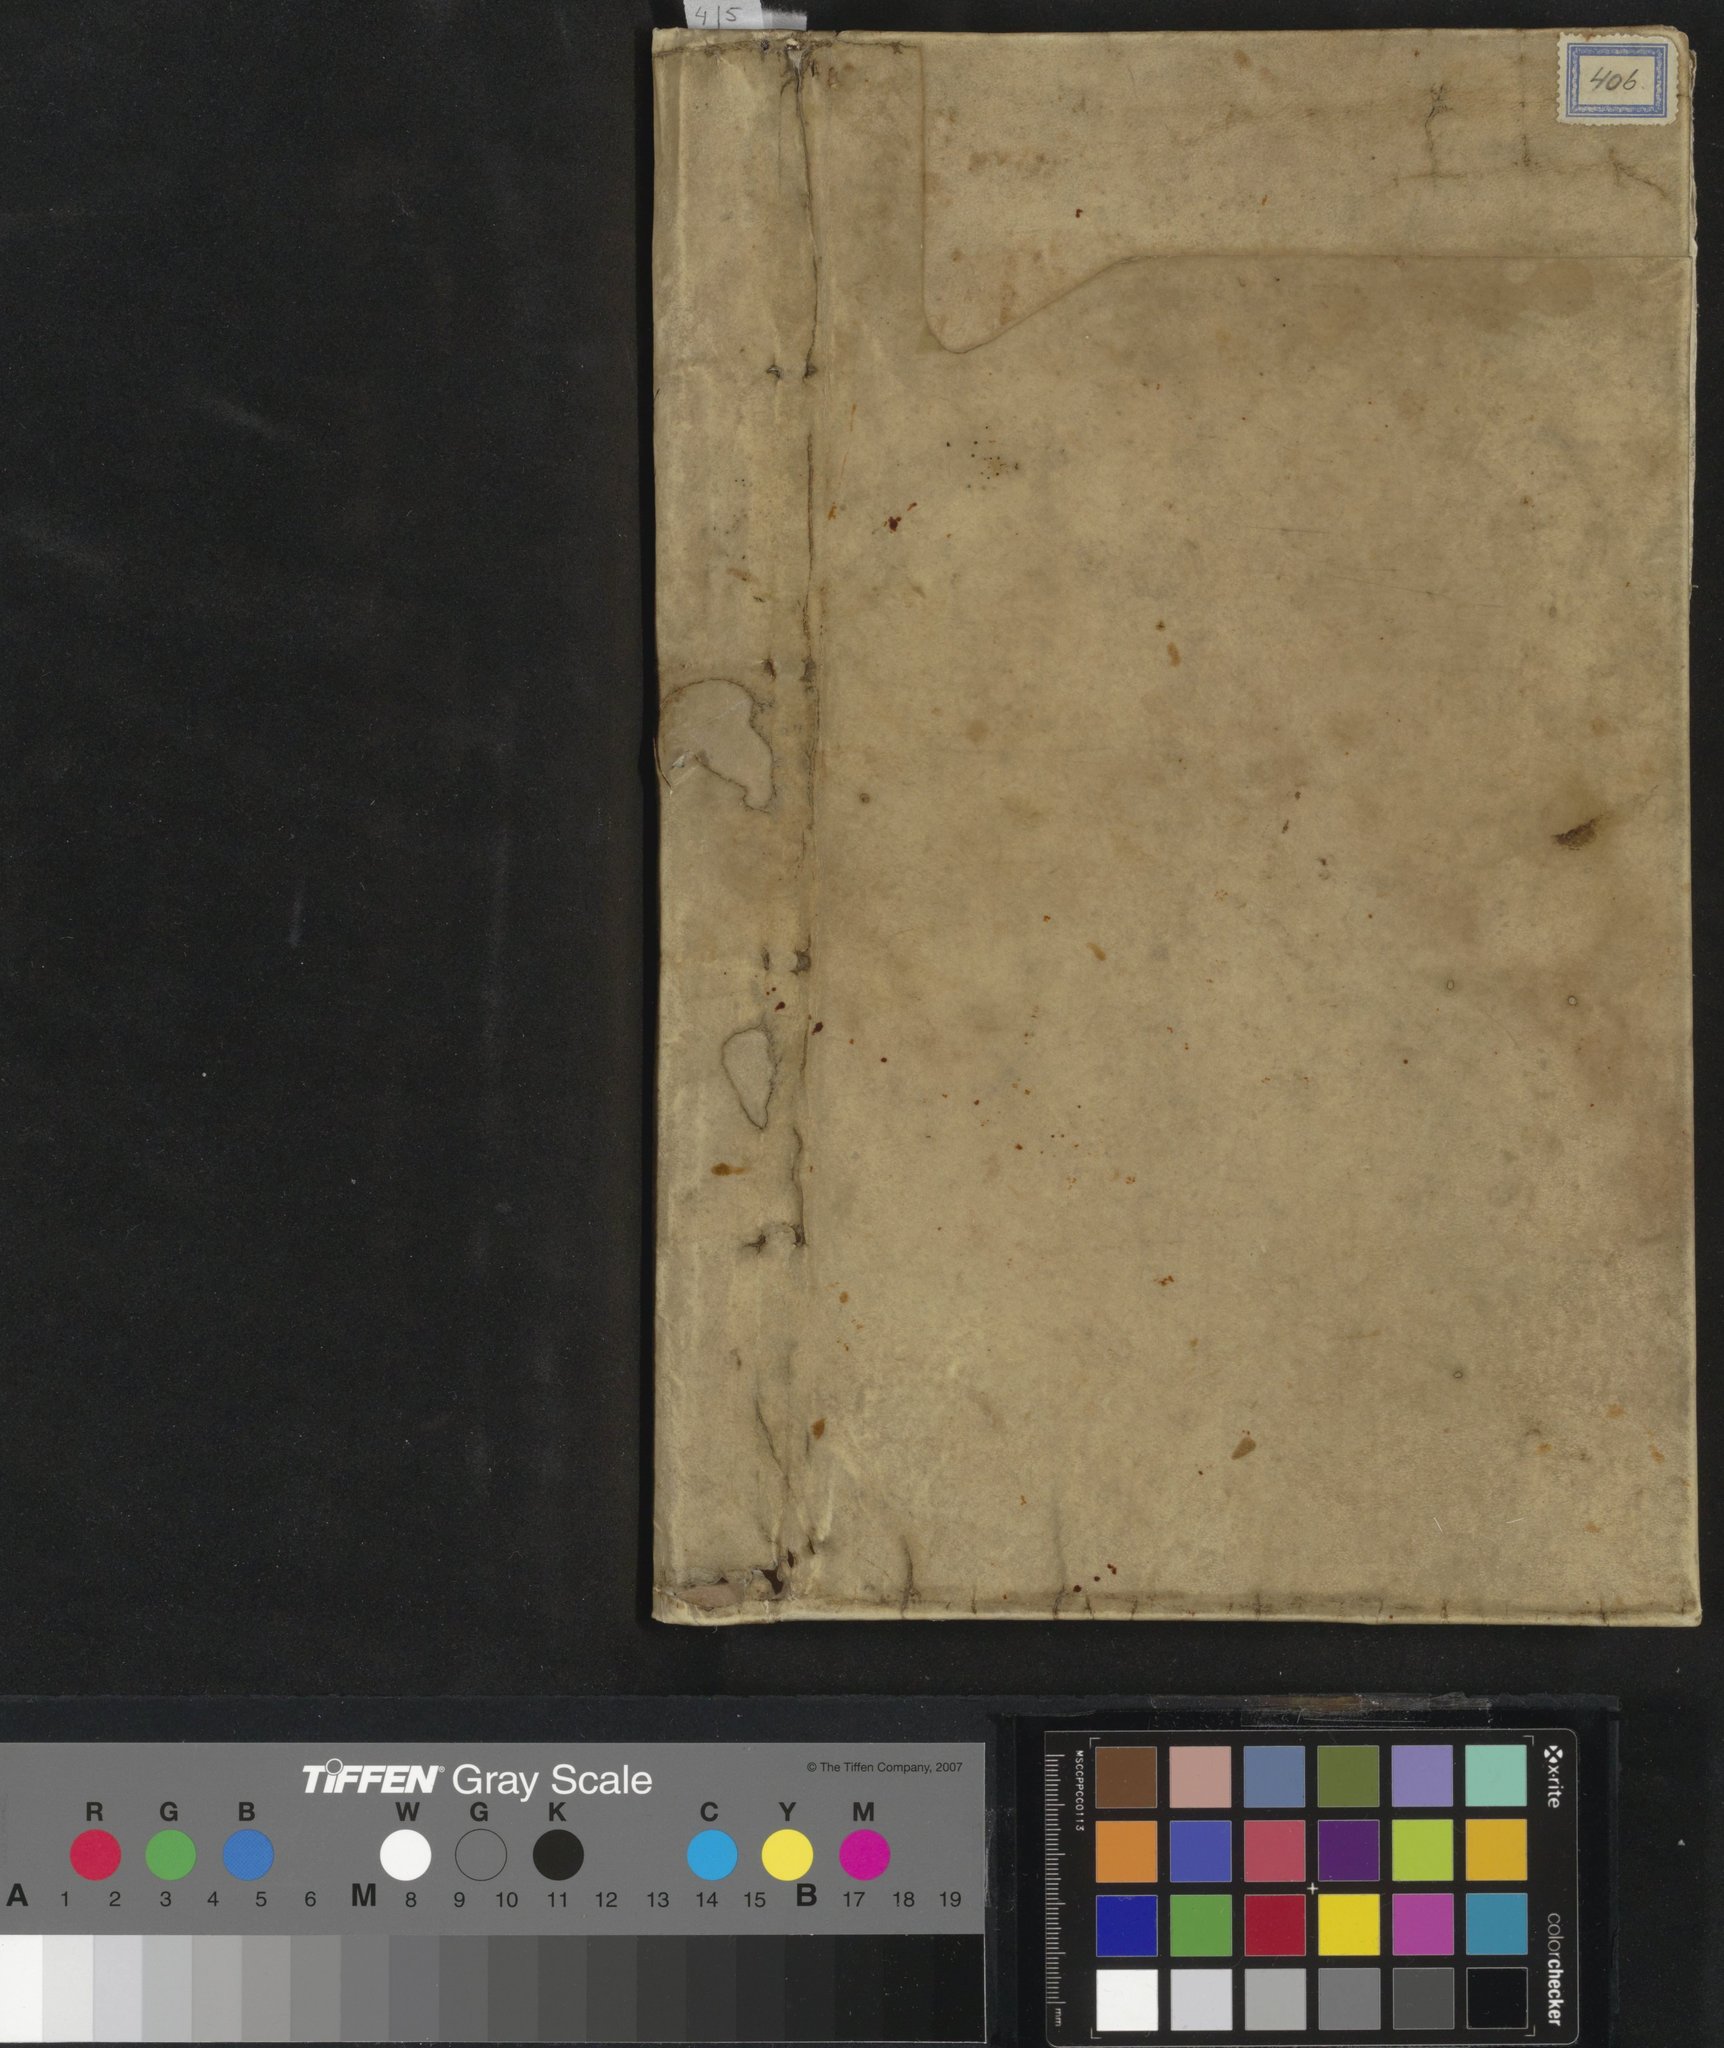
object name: sketchbook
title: Schetsboek met 15 bladen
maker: paul de vos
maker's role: draughtsman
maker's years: 1595-1678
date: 1605-1678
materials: chalk, ink, paper, parchment, pencil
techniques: brush, pen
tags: animals (+ animal killed by man), laid table as still life, foodstuffs; still life of foodstuffs, kitchen-interior with foodstuffs in foreground (dutch: 'keukenstuk')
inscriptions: annotation: ‘263/ Studie Boek/ van/ Paulus de Vos.’, name: ‘Paulus de Vos’, number: ‘406.’, collector's mark: Lugt 2228a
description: Schetsboek bestaande uit 15 bladen met keukenstukken en stillevens met bloemen en voedsel.